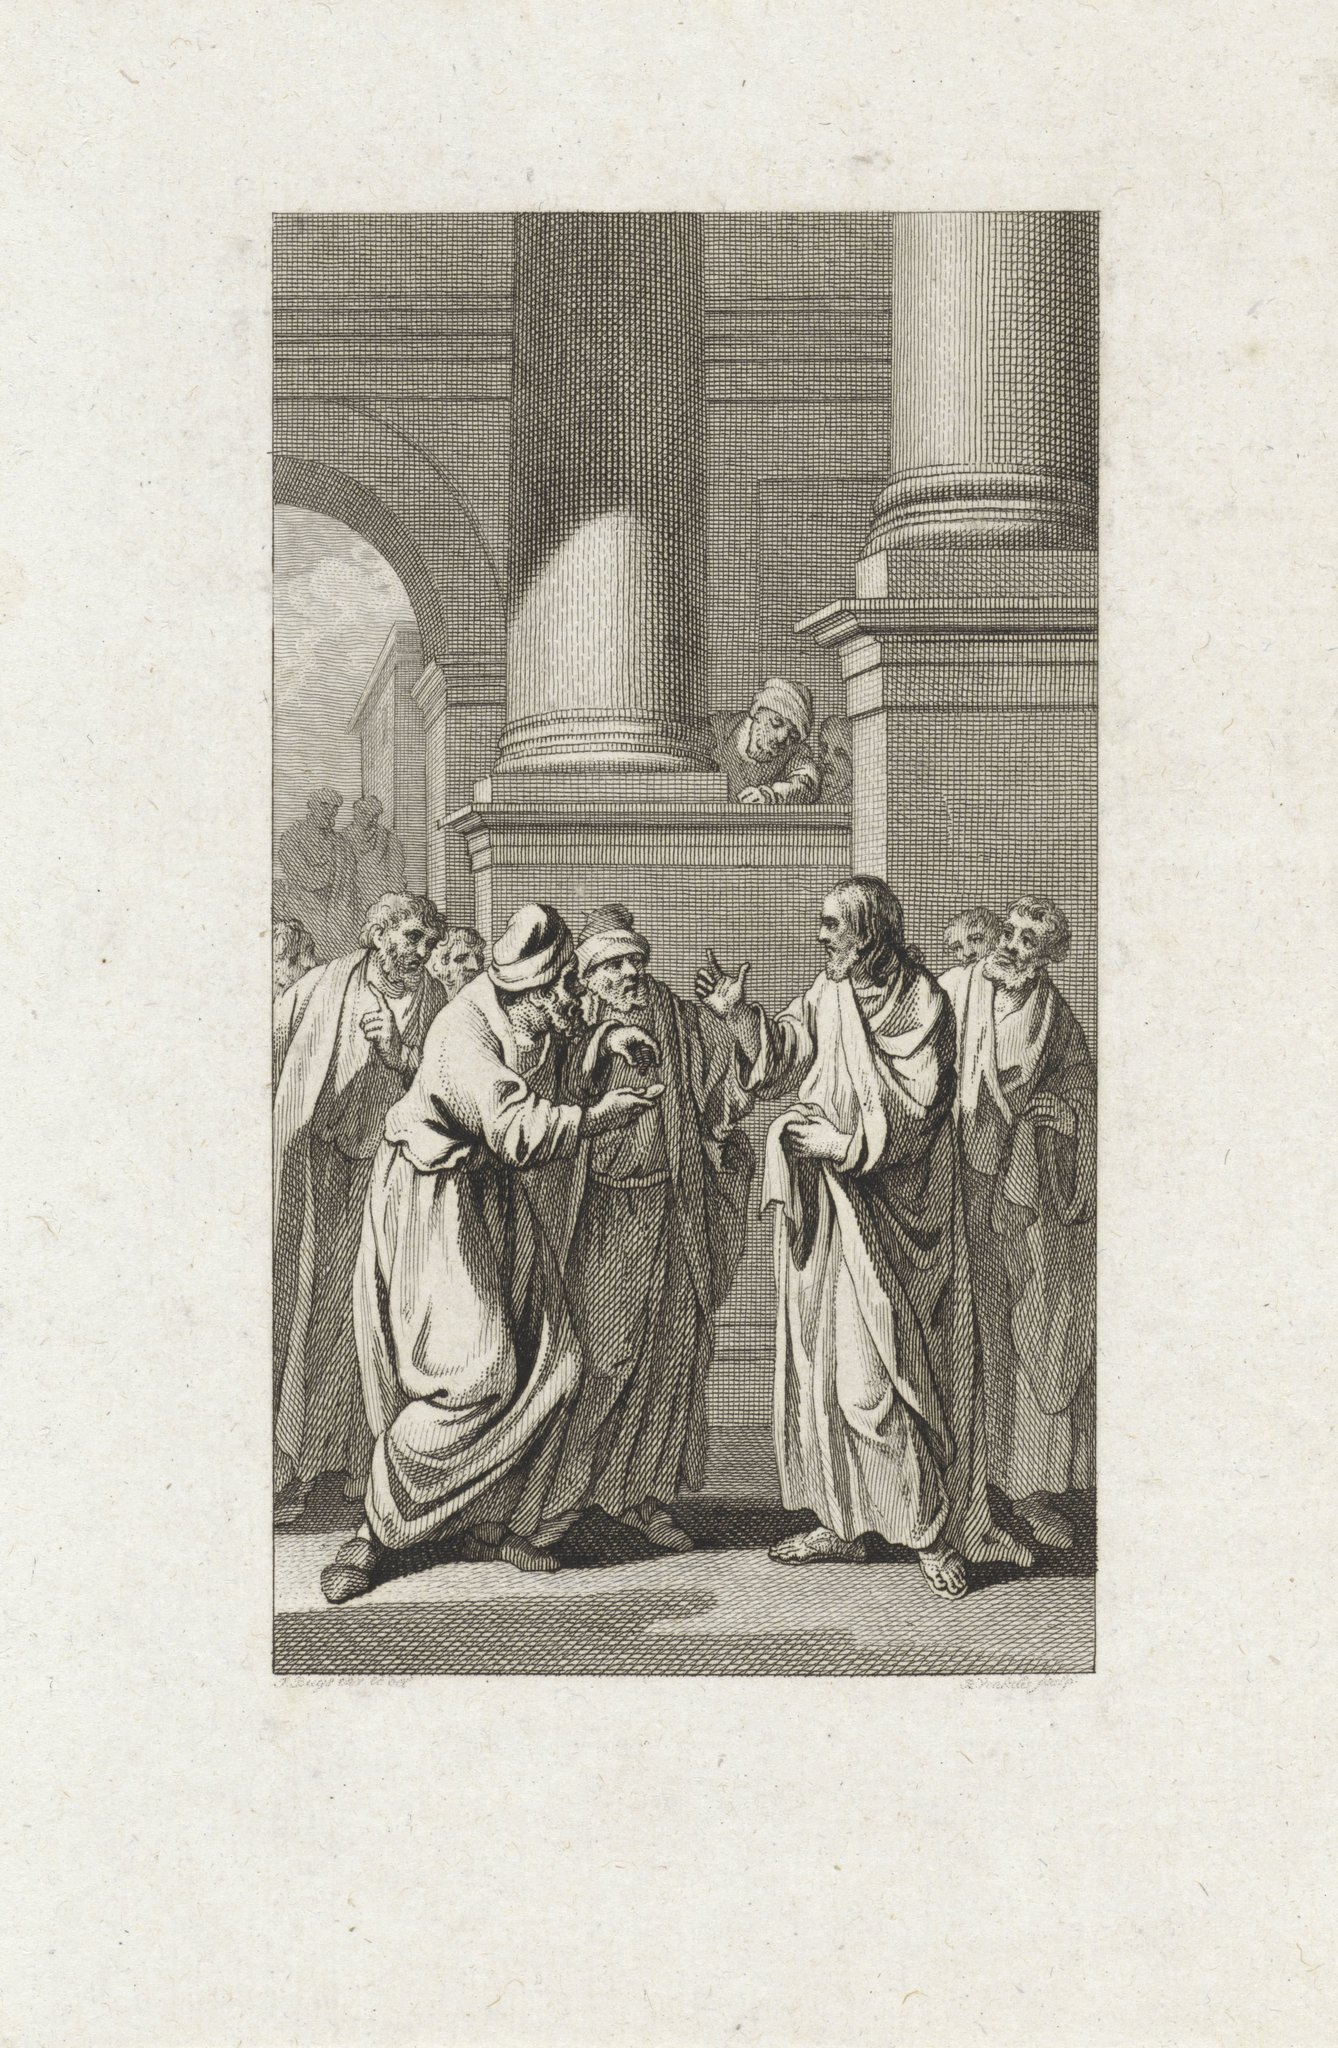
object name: print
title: Christus in debat met Farizeeën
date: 1751-1816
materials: paper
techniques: engraving, etching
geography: amsterdam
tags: christ (in the temple) in debate with pharisees about the tribute to caesar (matthew 22:15-22; mark 12:13-17; luke 20:20-26)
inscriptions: collector's mark: Lugt 2228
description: Christus is in gesprek met de Farizeeën over de vraag of het geoorloofd is belasting aan de keizer te betalen. Een van de Farizeeën, toont Christus een penning.